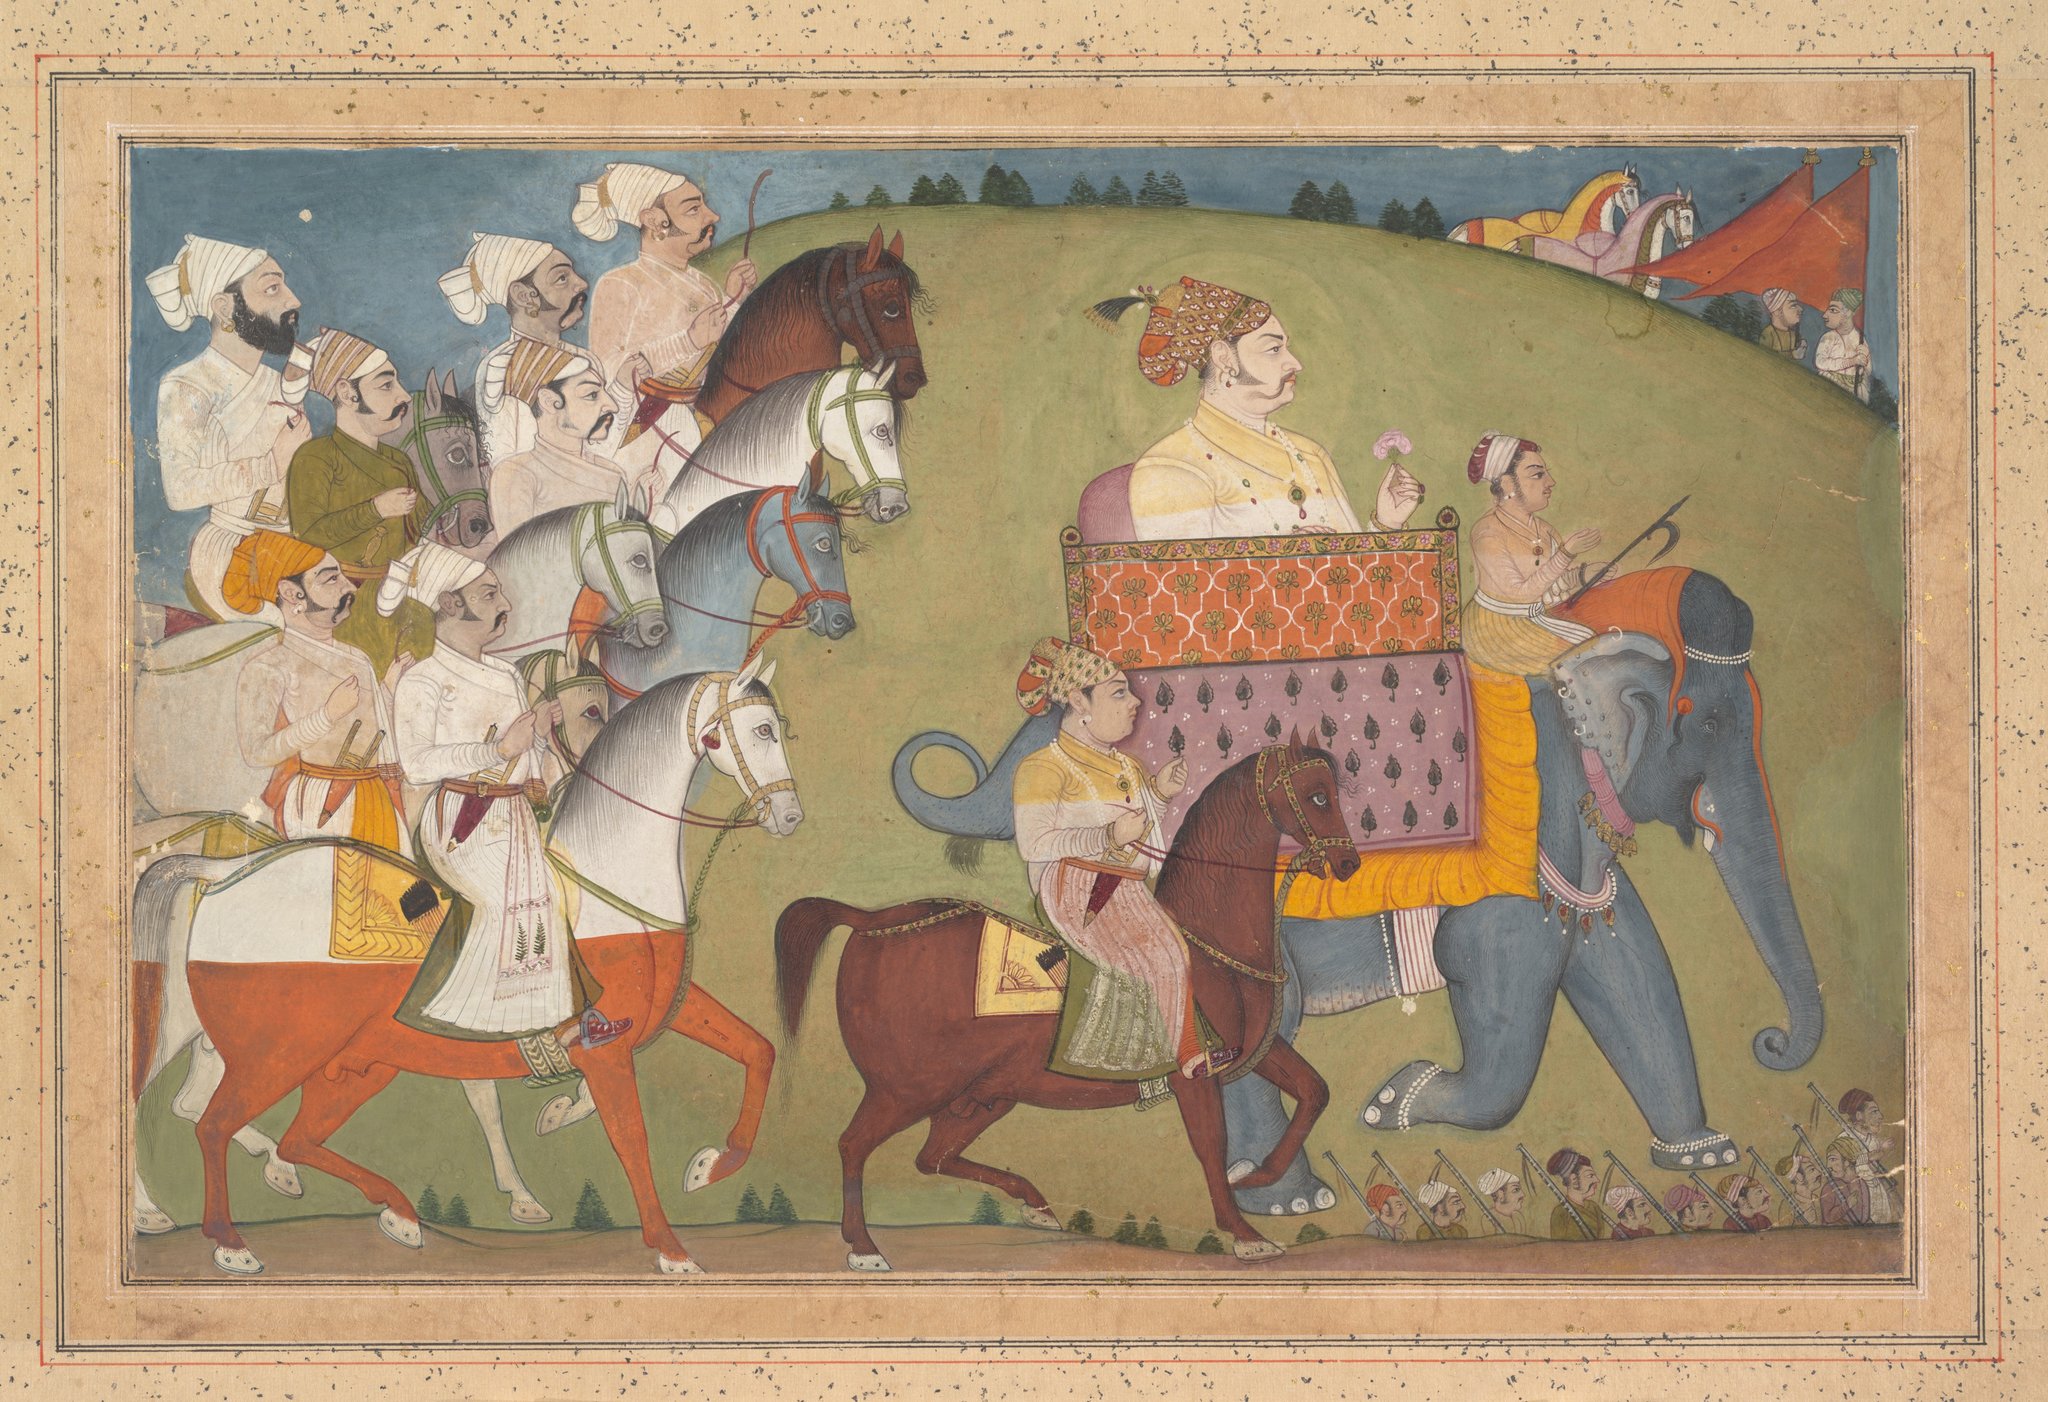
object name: painting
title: Maharaja Raj Singh in Procession with Members of His Court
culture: indian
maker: nihal chand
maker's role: artist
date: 1700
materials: gold, ink, paper, watercolor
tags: men,elephants,horses,processions